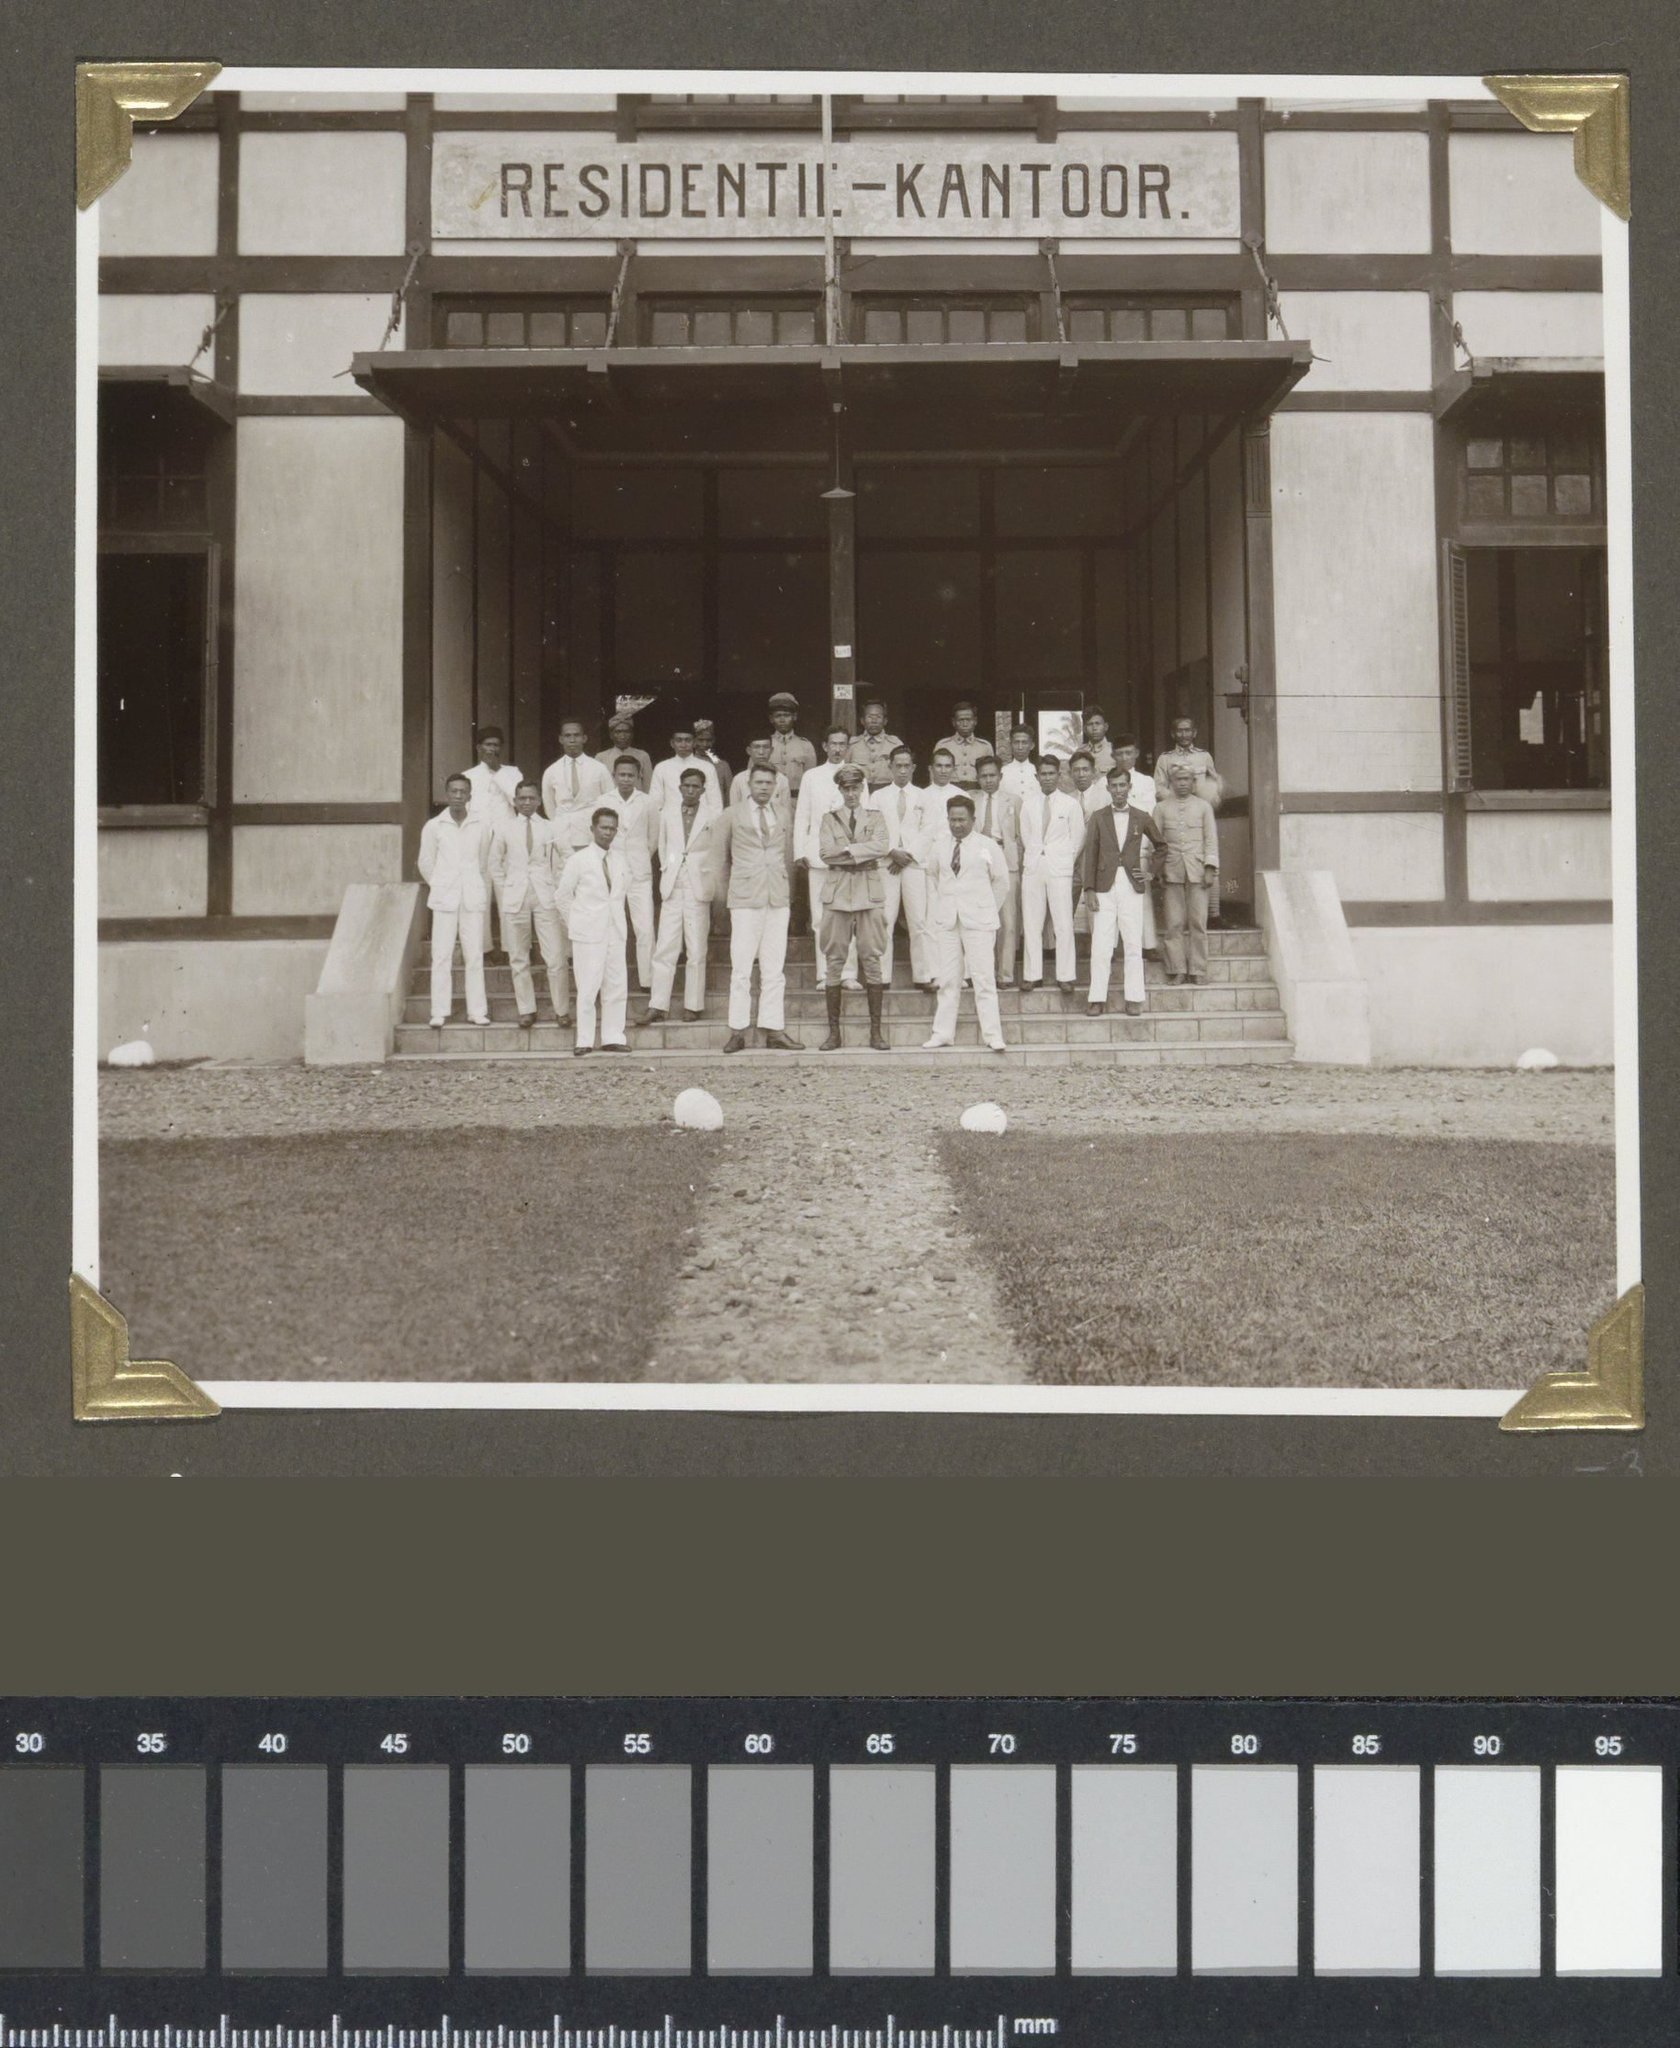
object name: photograph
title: Administratie personeel van het Residentiekantoor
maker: Anonymous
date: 1932-1933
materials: photographic support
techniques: gelatin silver print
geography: lampung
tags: colonial government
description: Onderdeel van Herinneringsalbum voor F.J. Junius, vertrekkend resident van Lampong (Zuid-Sumatra).